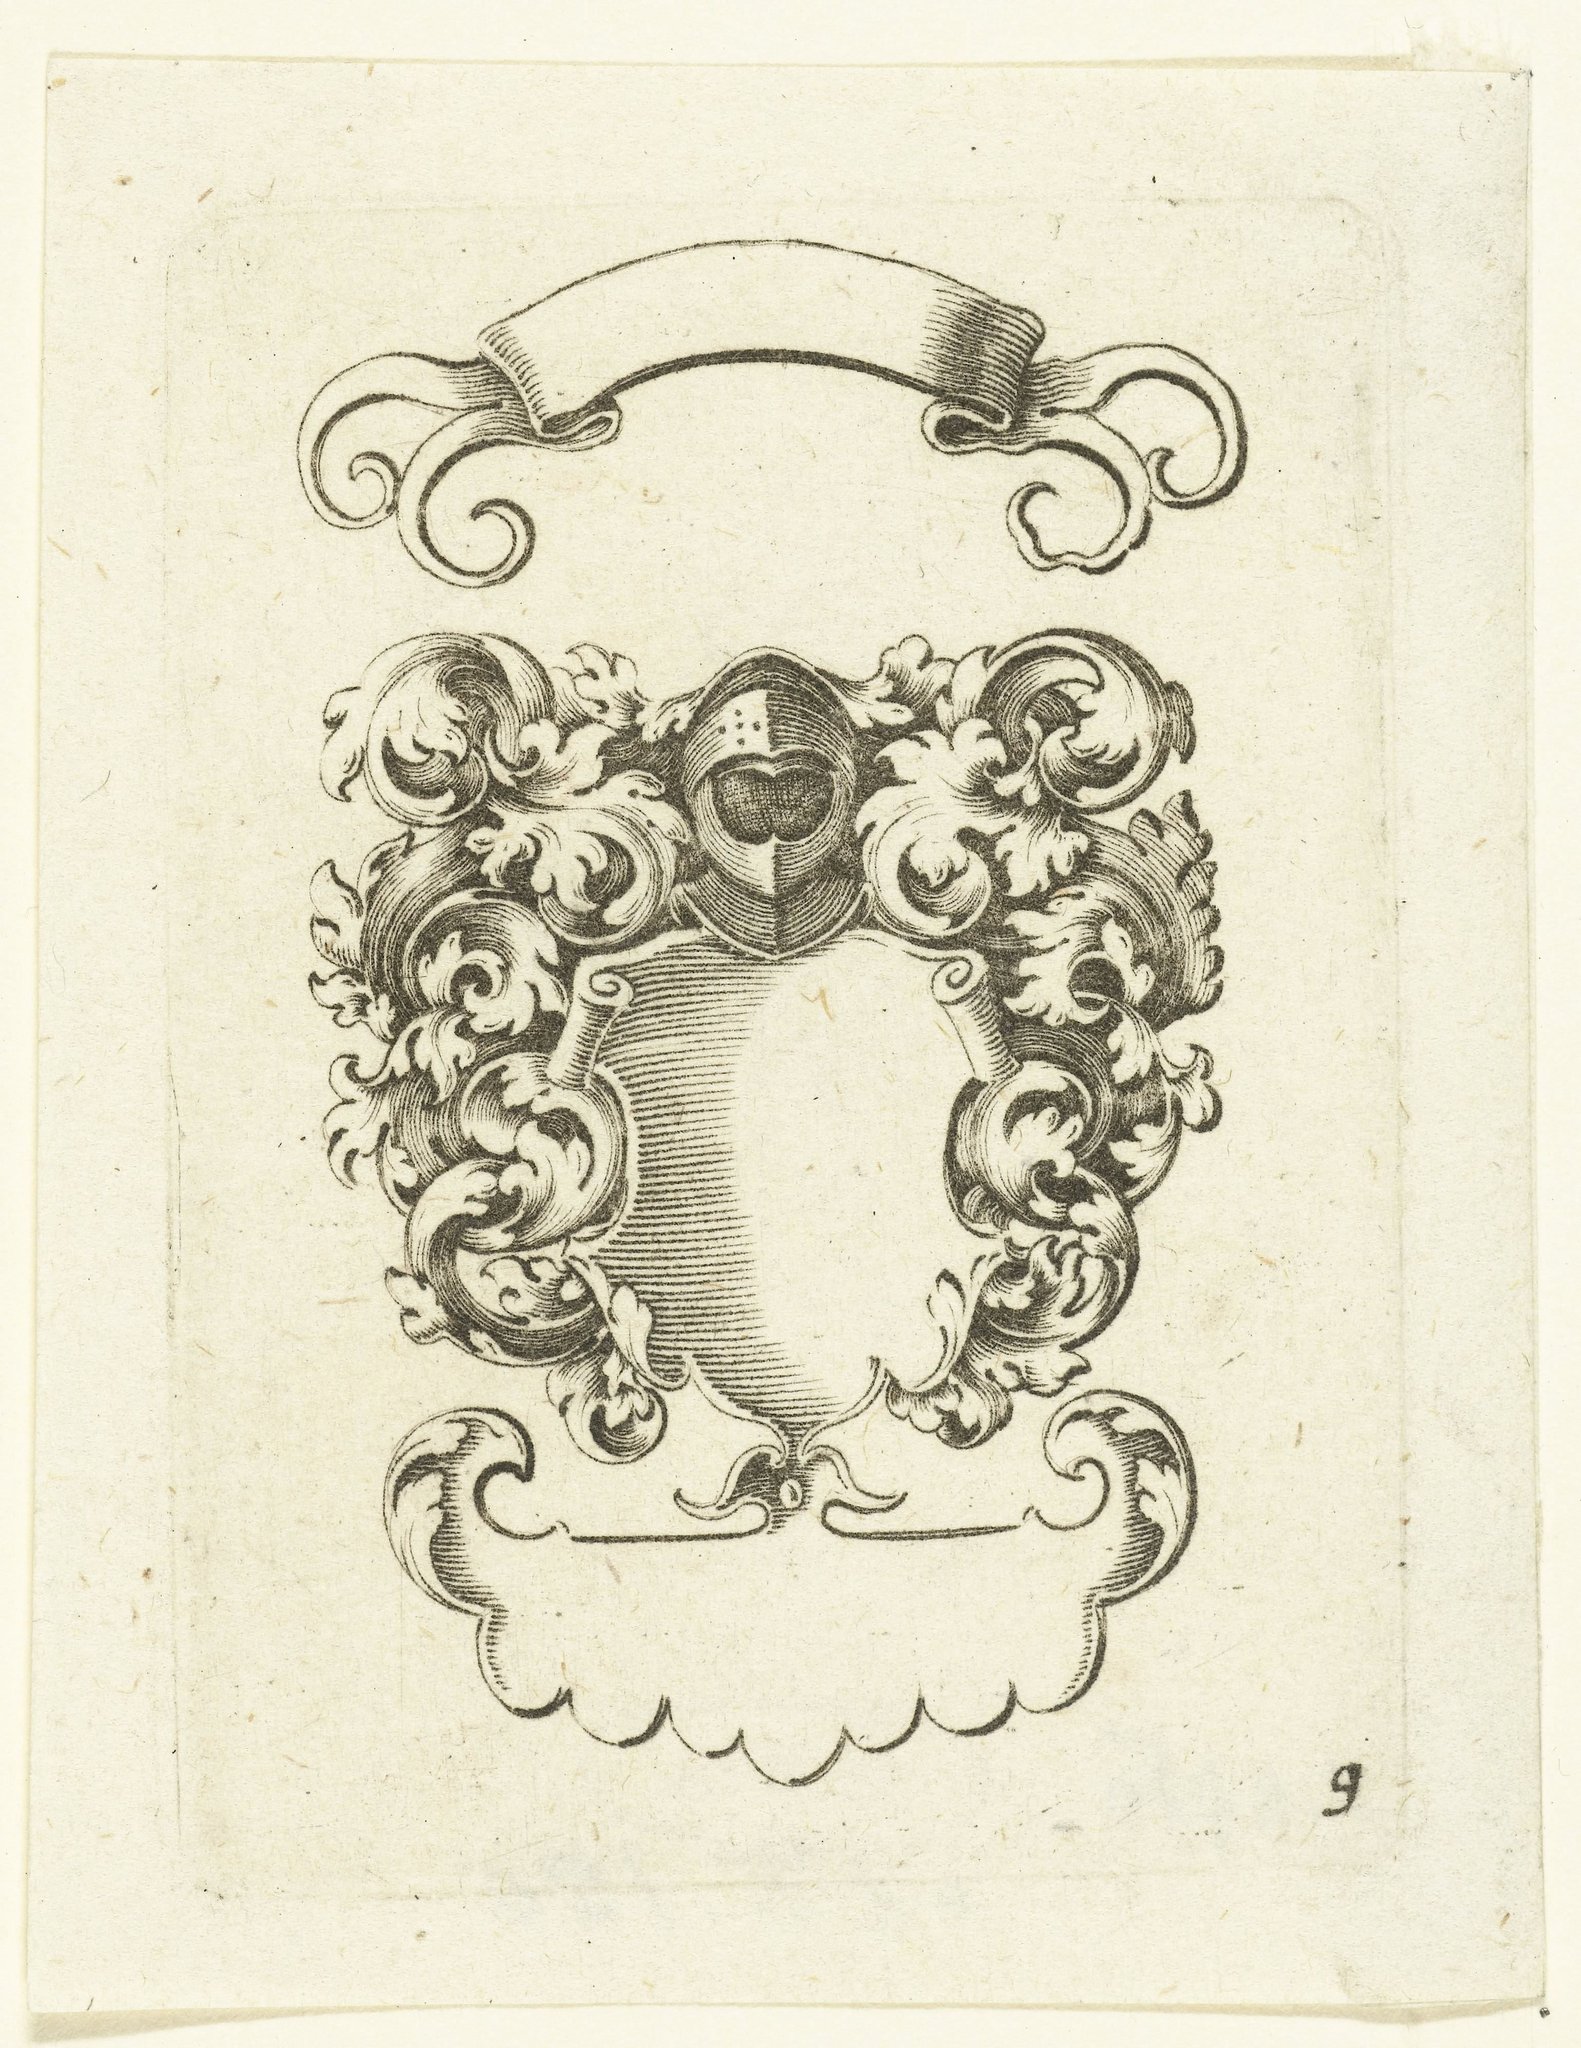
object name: print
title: Wapenschilden met lege velden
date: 1627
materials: paper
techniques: engraving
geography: amsterdam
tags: armorial bearing, heraldry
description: Tegenzijdige kopie van het wapenschild, leeg.